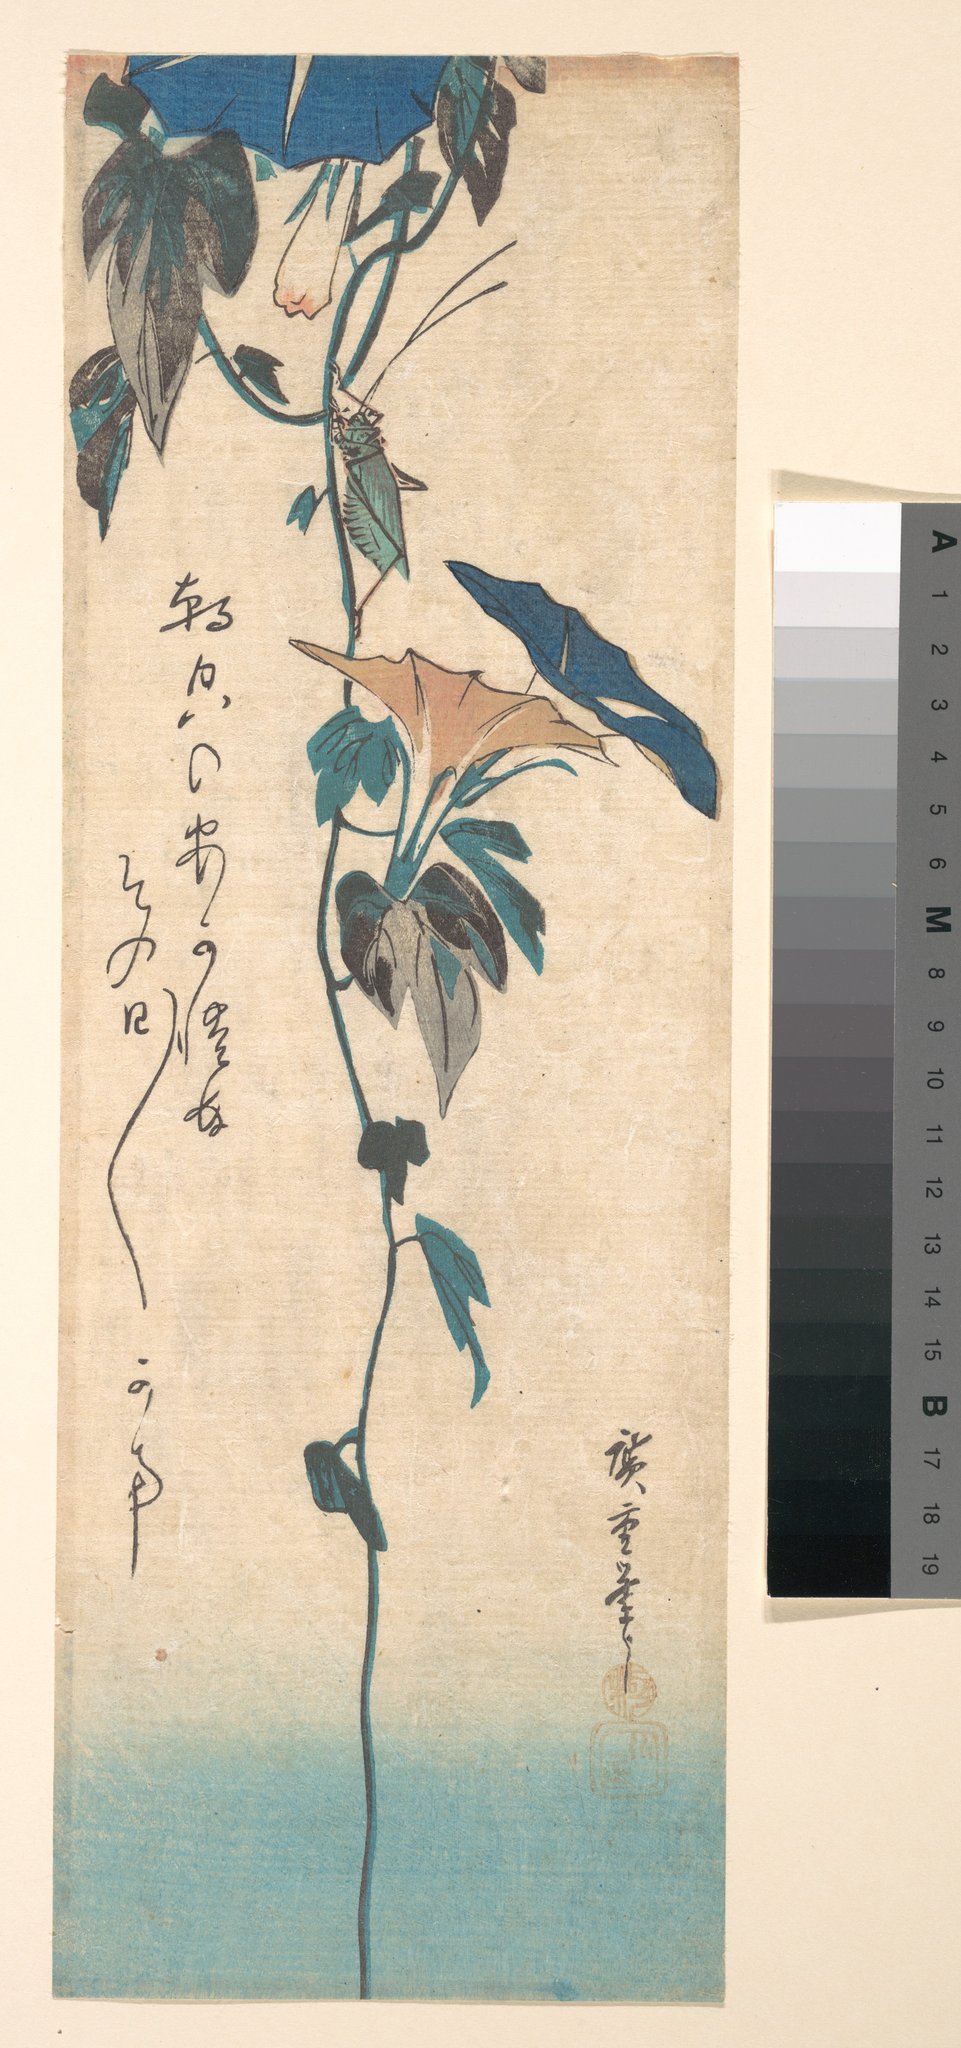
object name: print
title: Grasshopper and Morning-glory Vine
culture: japanese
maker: utagawa hiroshige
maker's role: artist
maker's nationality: japanese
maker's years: 1797-1858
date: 1835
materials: ink, paper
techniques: woodblock print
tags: insects,flowers